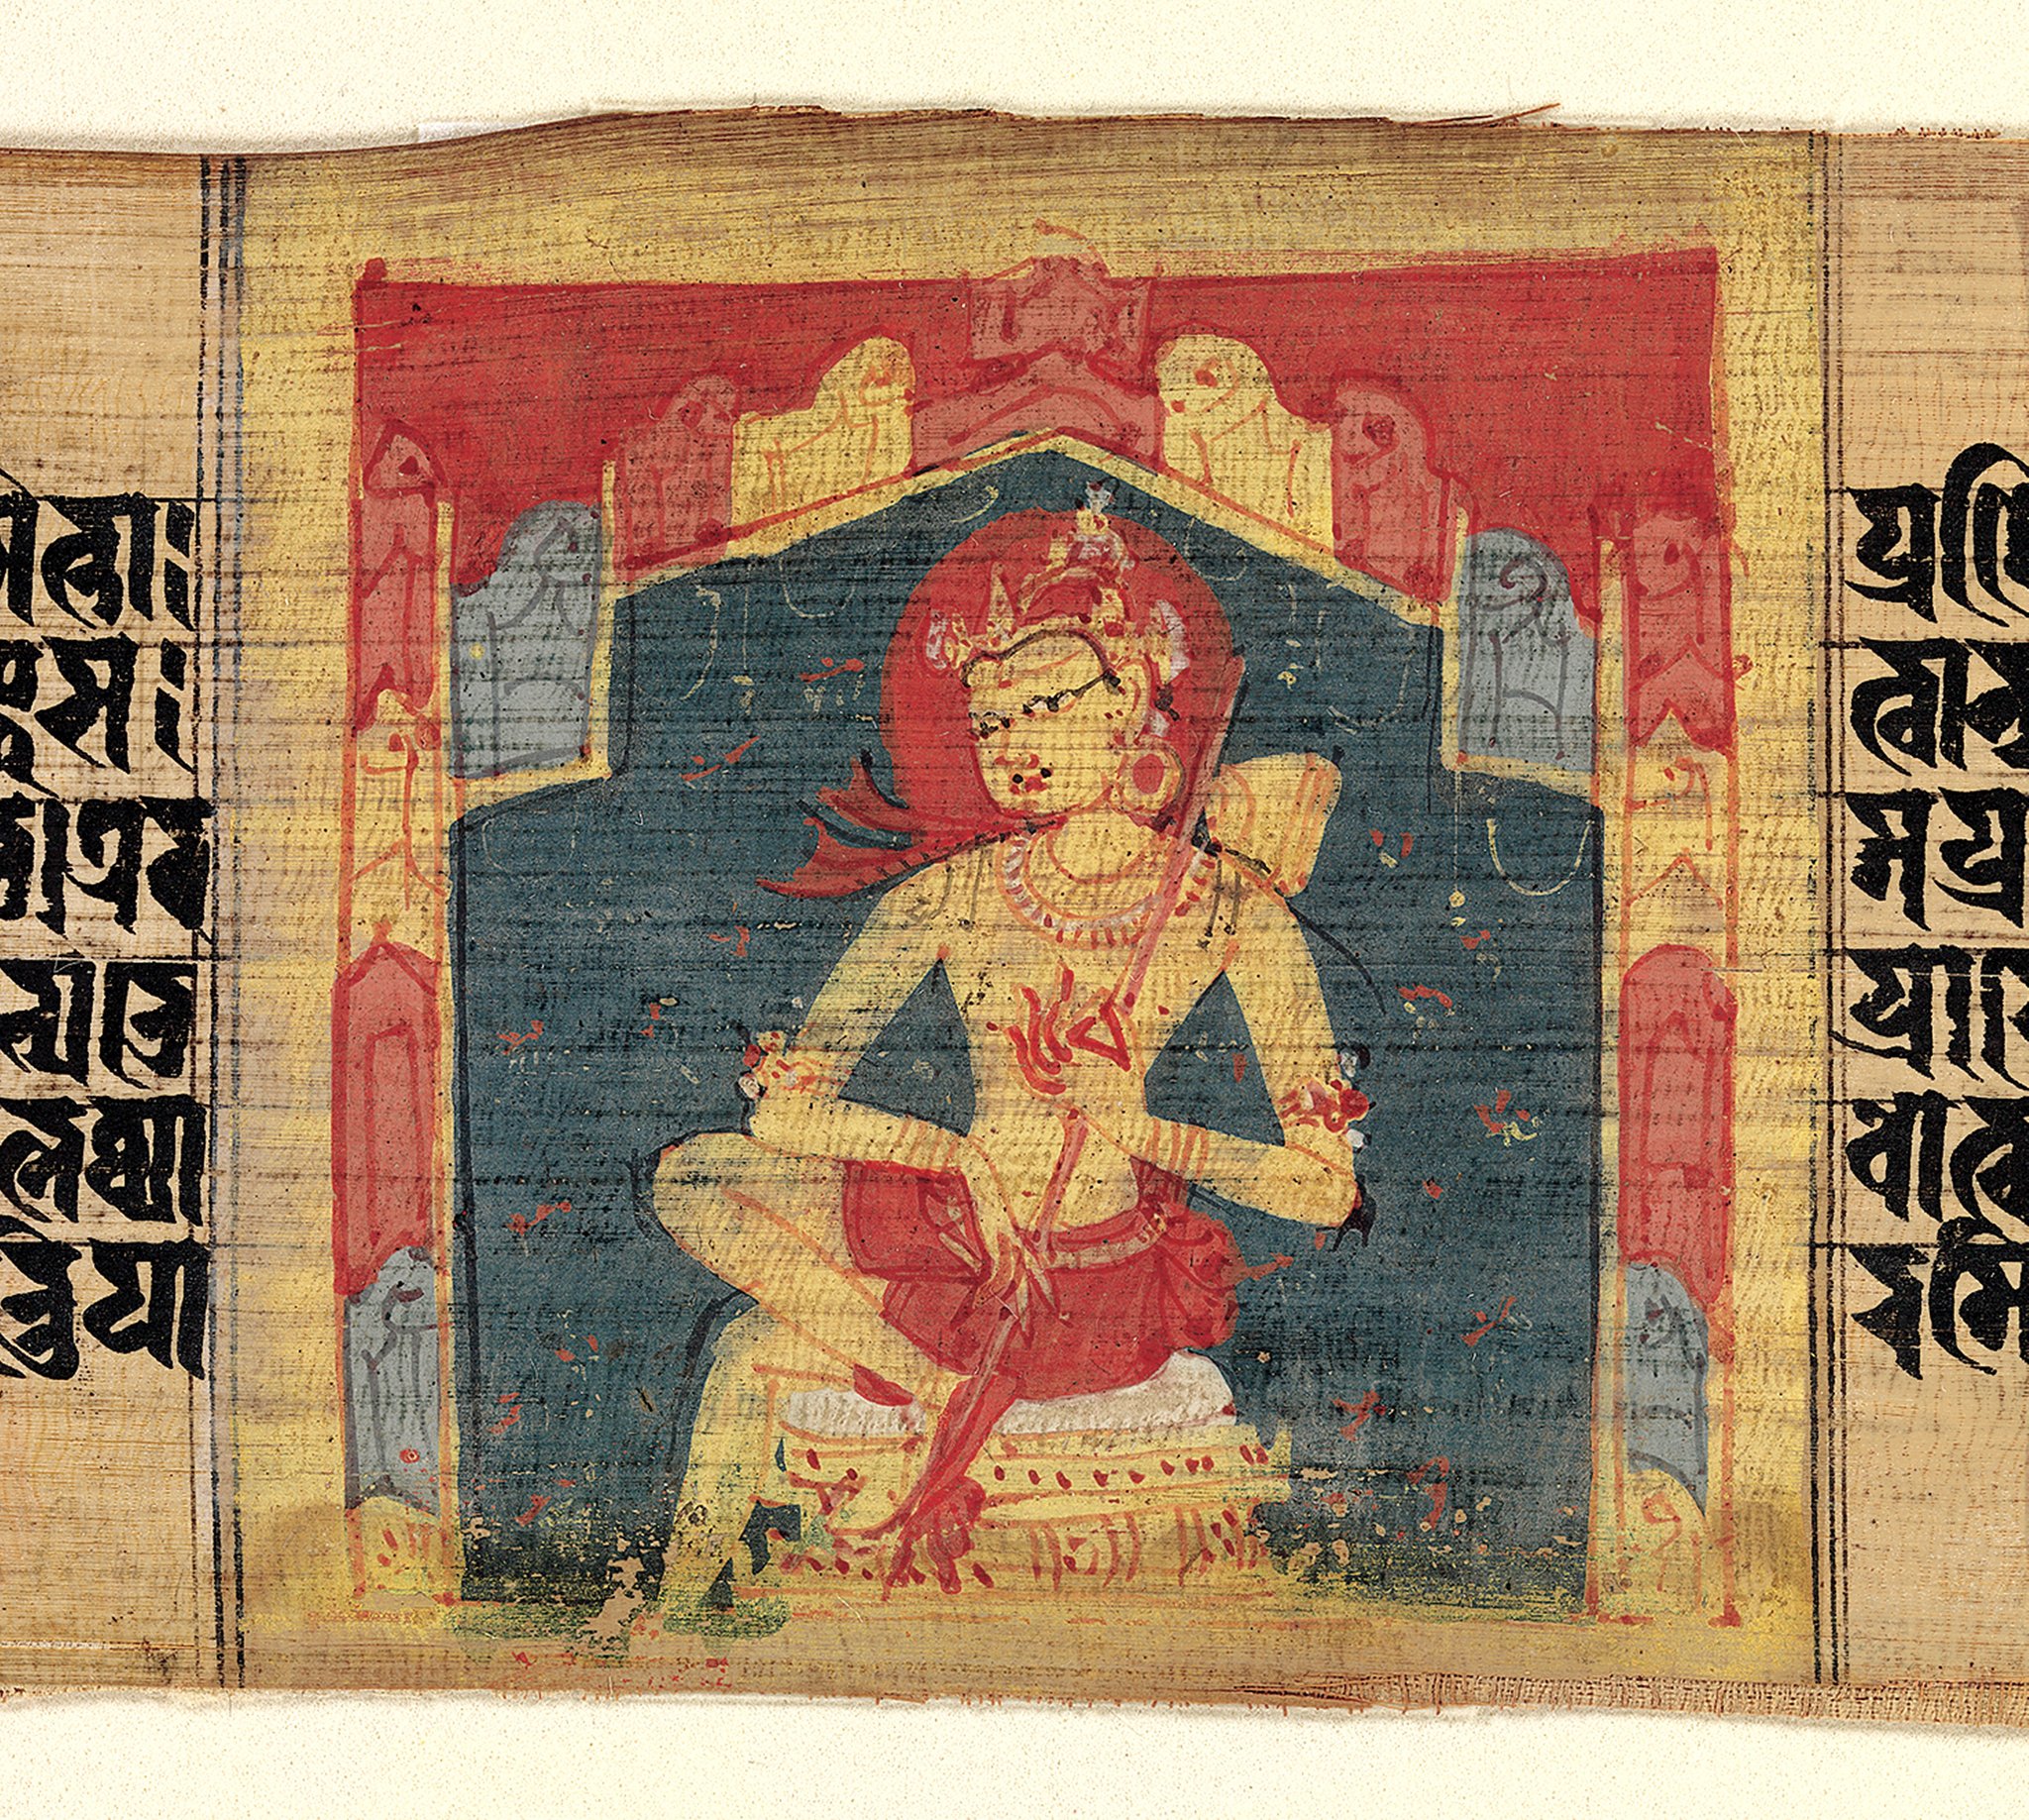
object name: folio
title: Bodhisattva in a Mountain Grotto, Playing a Stringed Instrument (Vina), Leaf from a Dispersed Pancavimsatisahasrika Prajnapramita Manuscript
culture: indian, bengal or bangladesh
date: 1090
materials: leaf, watercolor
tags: musical instruments,buddhism,bodhisattvas